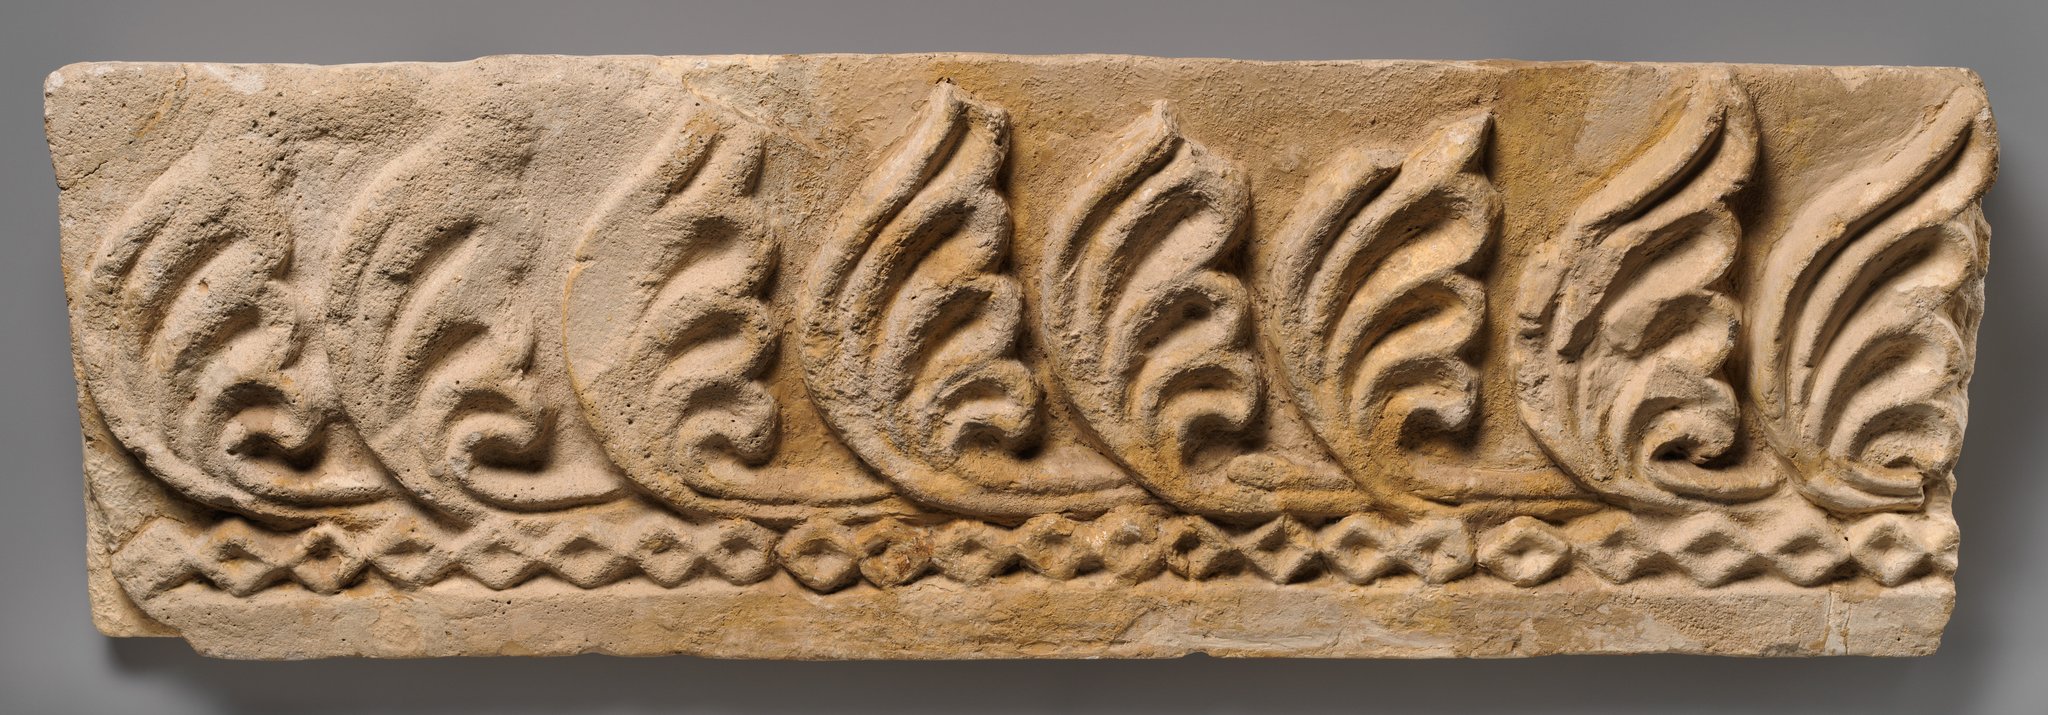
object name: relief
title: Wall decoration with vegetal and geometric design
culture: sasanian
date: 501-600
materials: plaster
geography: mesopotamia